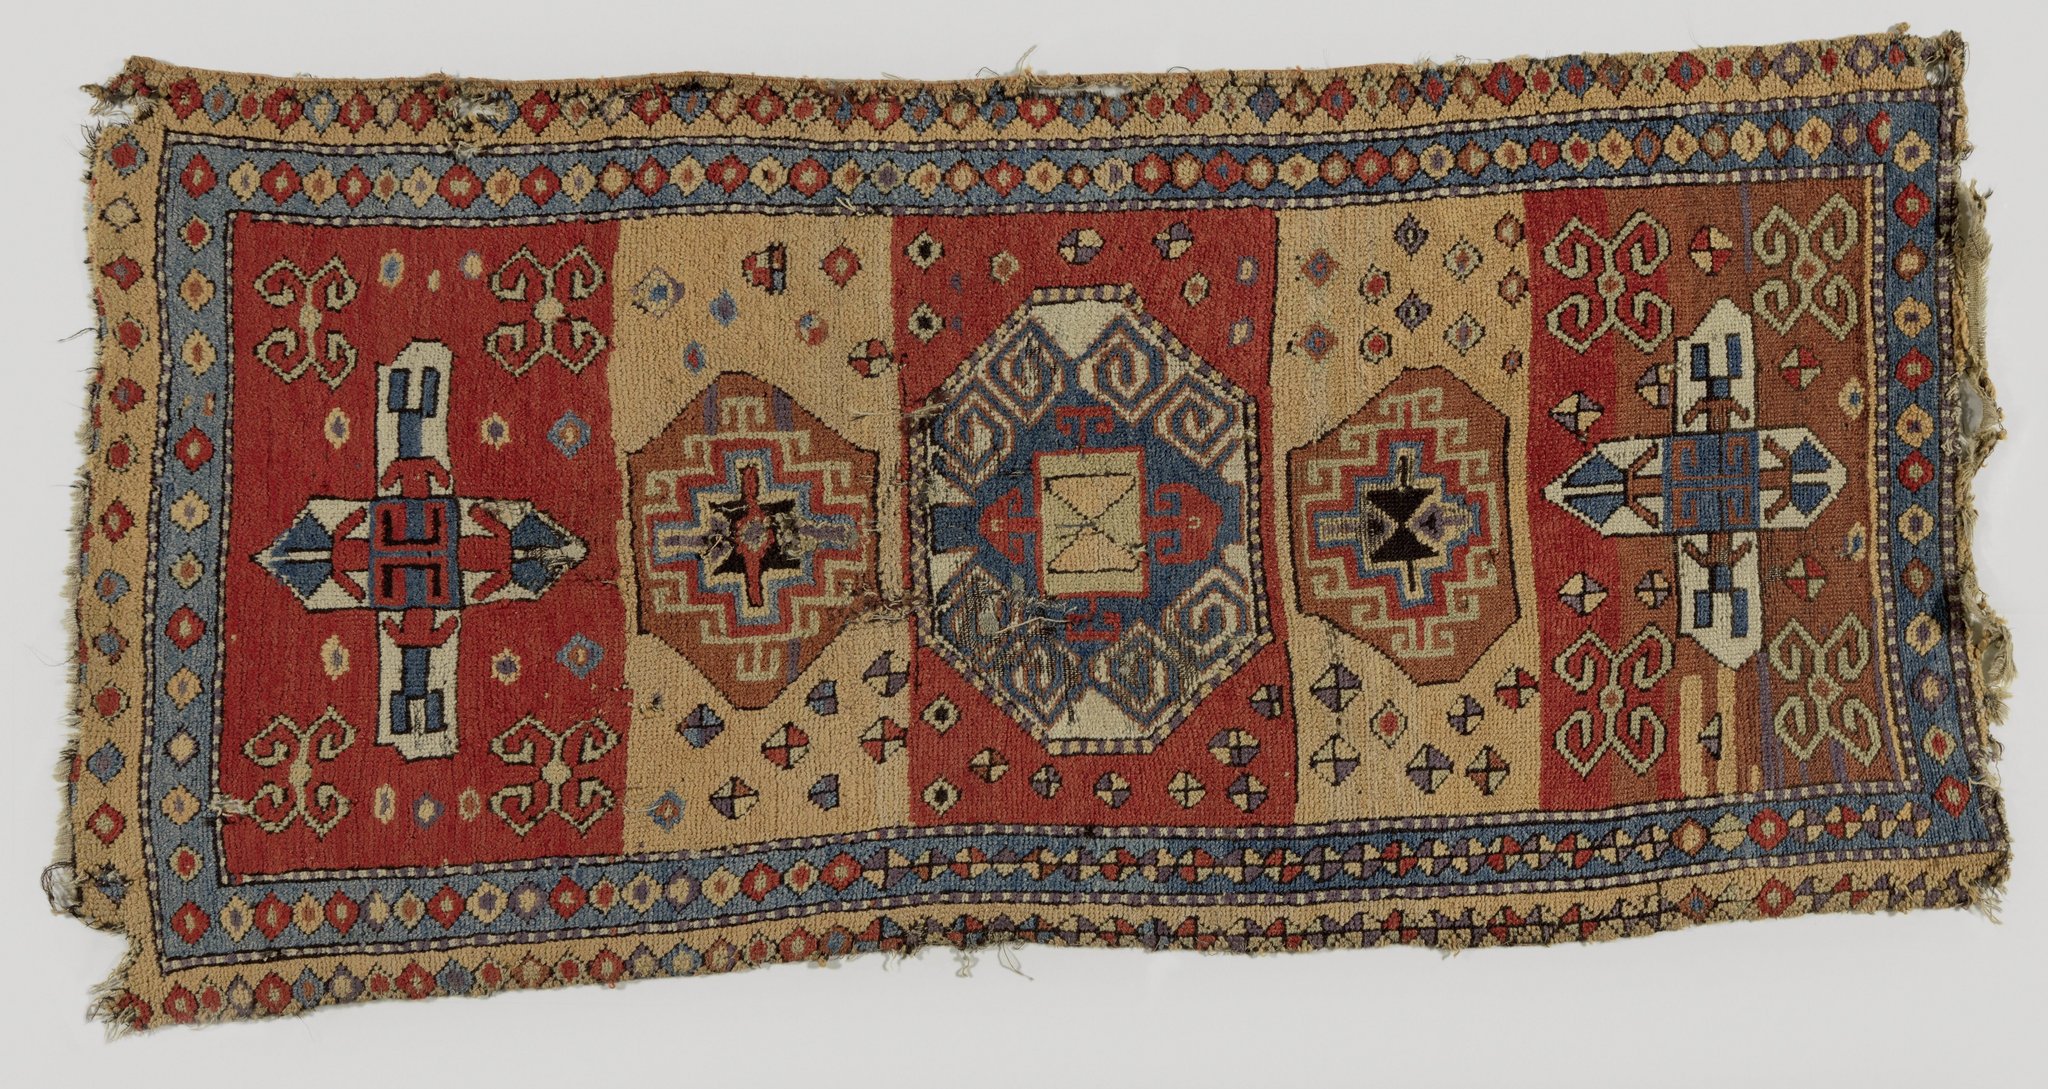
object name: oriental rug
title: Oosters tapijt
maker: Anonymous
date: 1850-1900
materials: wool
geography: caucasus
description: Oosters tapijt, perkenkleed, waarvan het middenveld verdeeld is in vijf dwarsvelden met in het midden van elk een medaillon. Randen versierd met zeshoeken.